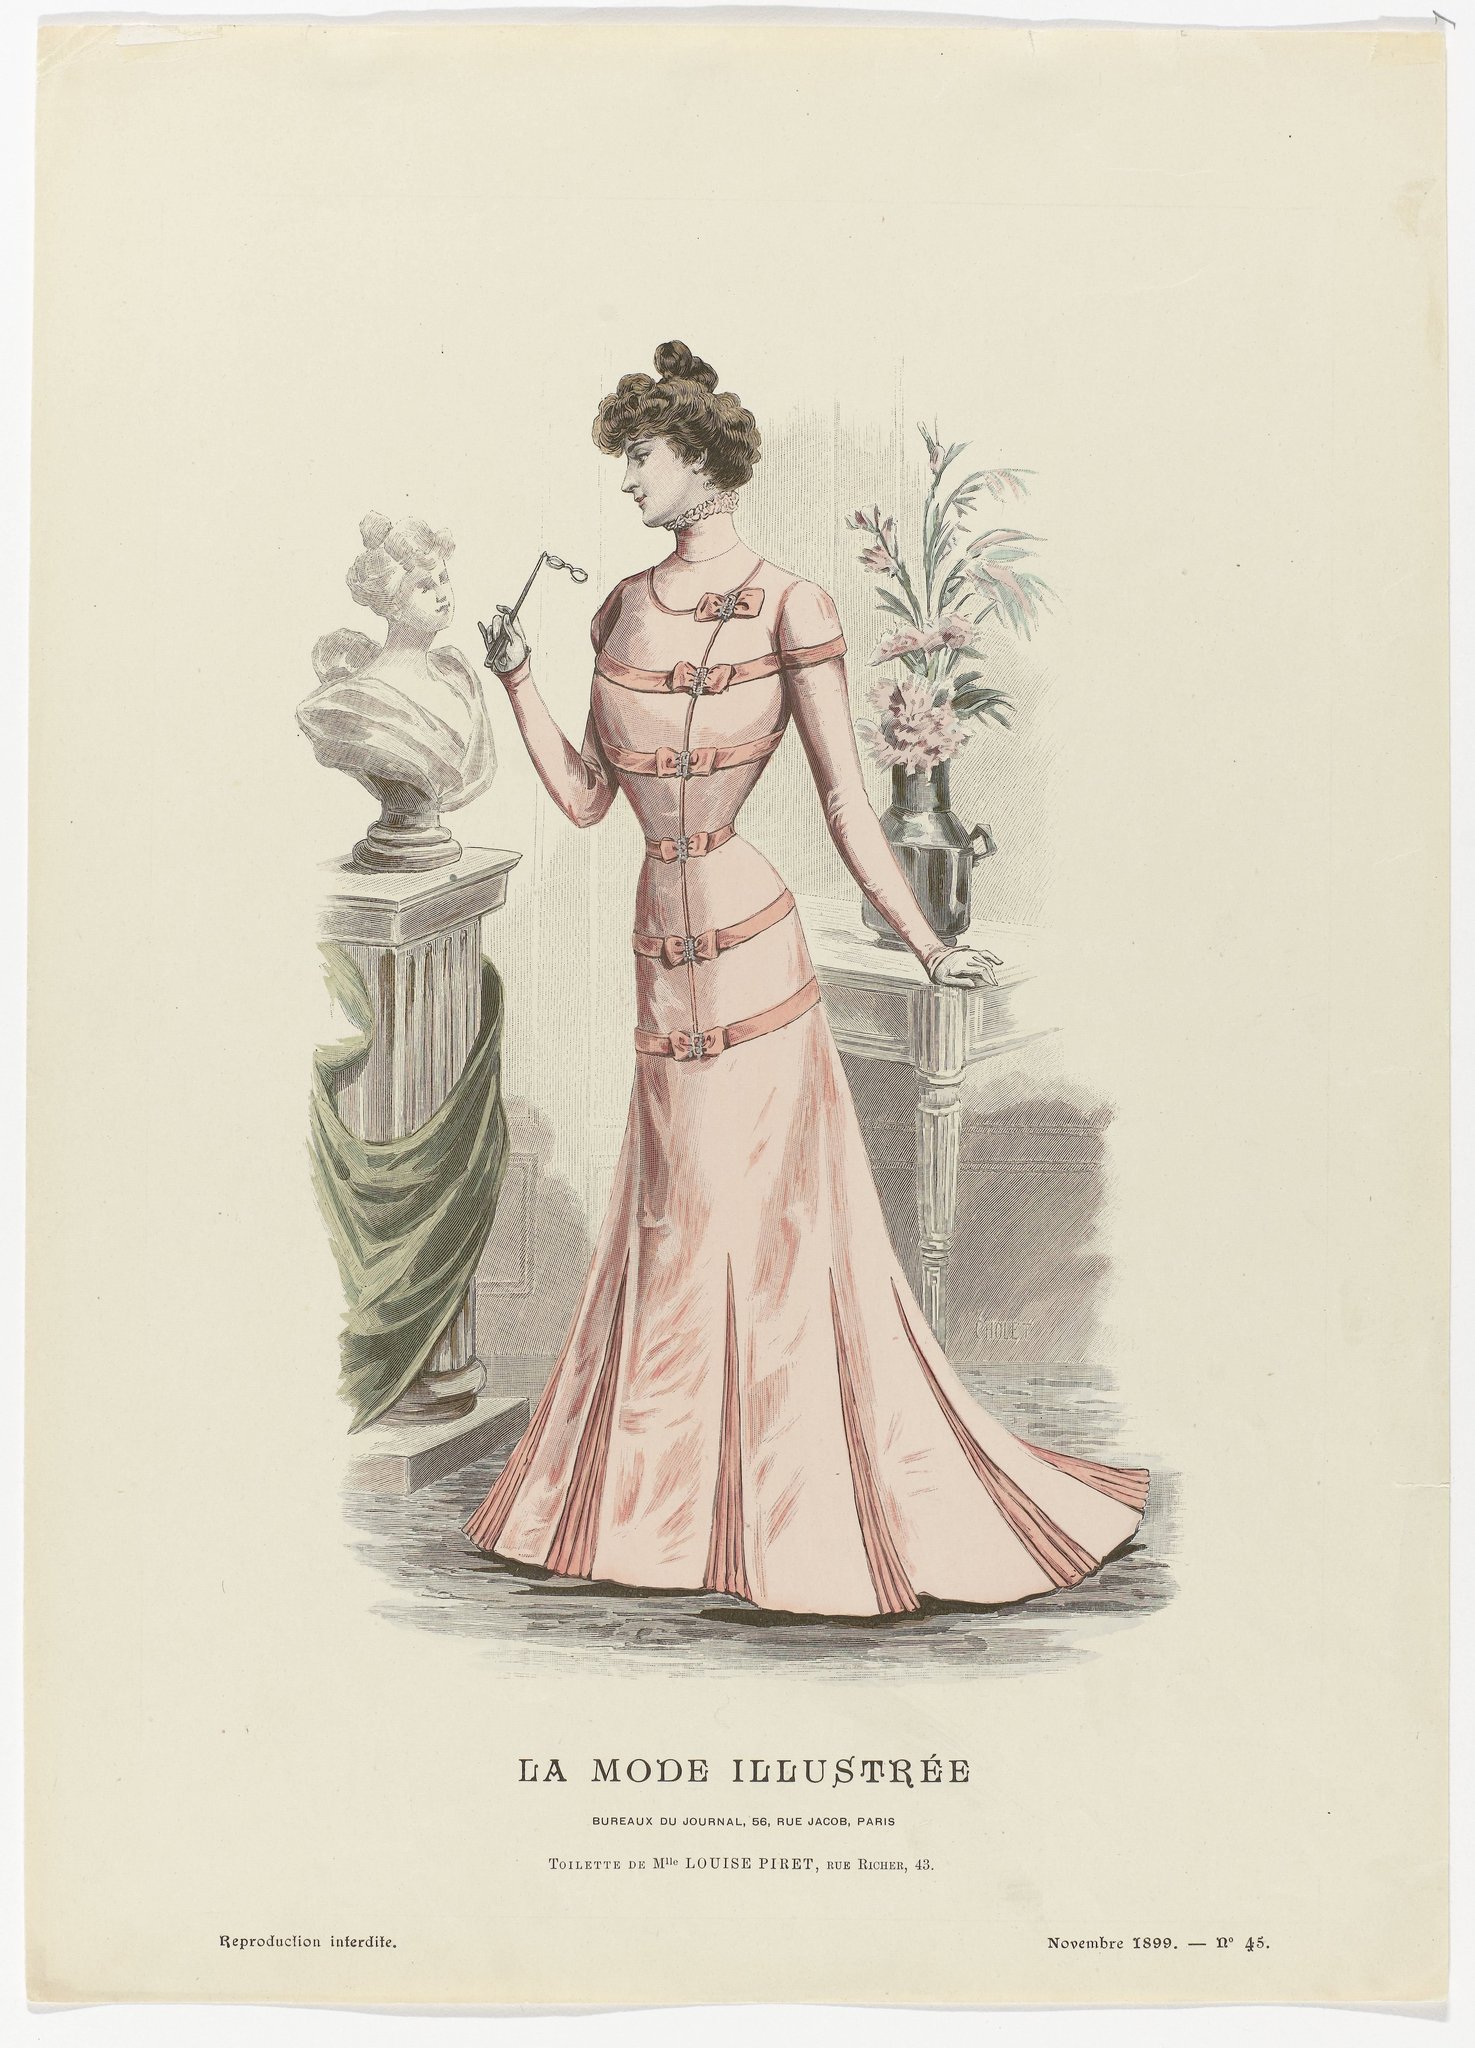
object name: fashion print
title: La Mode Illustrée, Novembre 1899, No. 45 : Toilette de Mlle Louise Piret (...)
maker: cholet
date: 1899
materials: paper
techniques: engraving, hand coloring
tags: bow (ornamental part of clothing) (+ women's clothes), eyeglasses, spectacles, fashion plates, dress, gown (+ women's clothes), piece of sculpture, reproduction of a piece of sculpture, flowers in a vase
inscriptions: title: ‘LA MODE ILLUSTRÉE’, caption: ‘TOILETTE DE Mlle LOUISE PIRET, RUE RICHER, 43’, address: ‘BUREAUX DU JOURNAL, 56, RUE JACOB, PARIS’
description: Vrouw met een lorgnet in de hand. Zij staat voor een tafel met bloemenvaas en kijkt naar een buste op een sokkel. Zij draagt een roze japon versierd met donkerroze horizontale banen en strikken. Uitwaaierende rok voorzien van plooien. Volgens het onderschrift: 'toilette' van Louise Piret. Prent uit het modetijdschrift La Mode Illustrée (1860-1937).